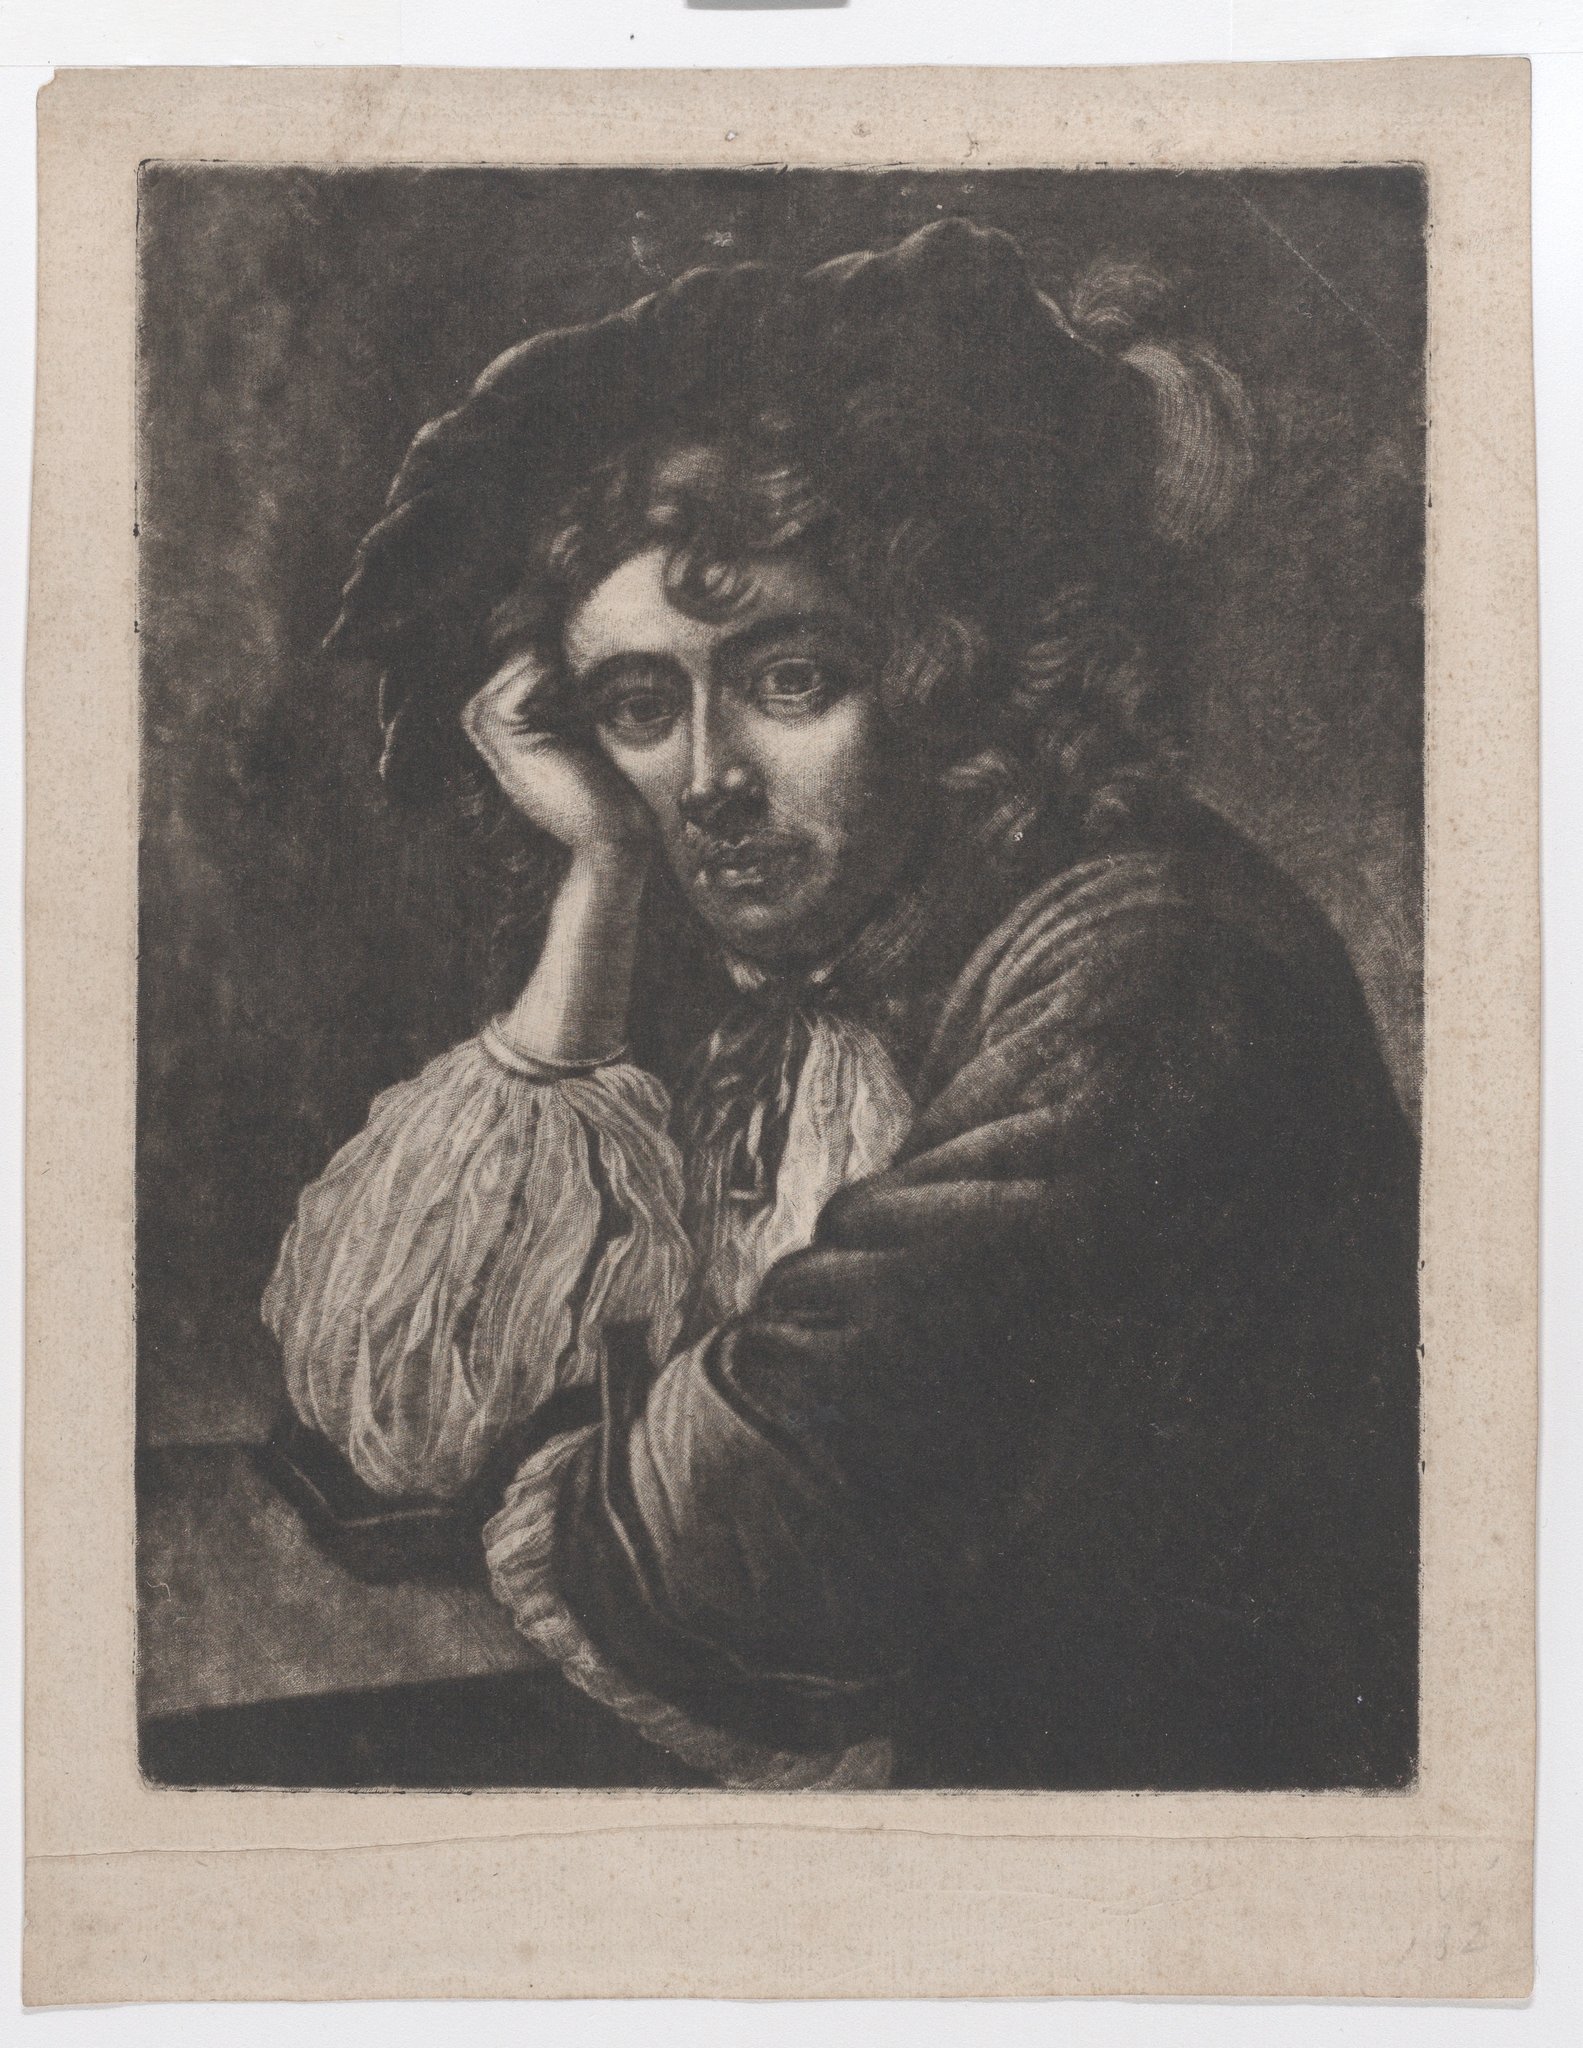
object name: print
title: Half-Length Portrait of a Young Man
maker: anonymous, german, 17th century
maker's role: artist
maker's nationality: german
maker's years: 1600-1700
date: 1654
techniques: mezzotint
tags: men,portraits